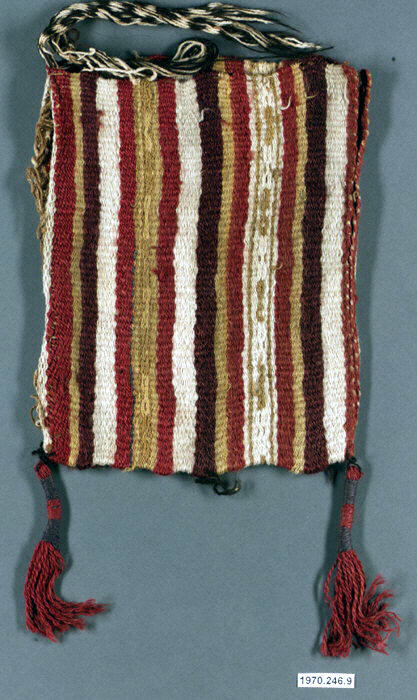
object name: bag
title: Bag with Tassels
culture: peruvian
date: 701-1600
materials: animal fiber, cotton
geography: peru